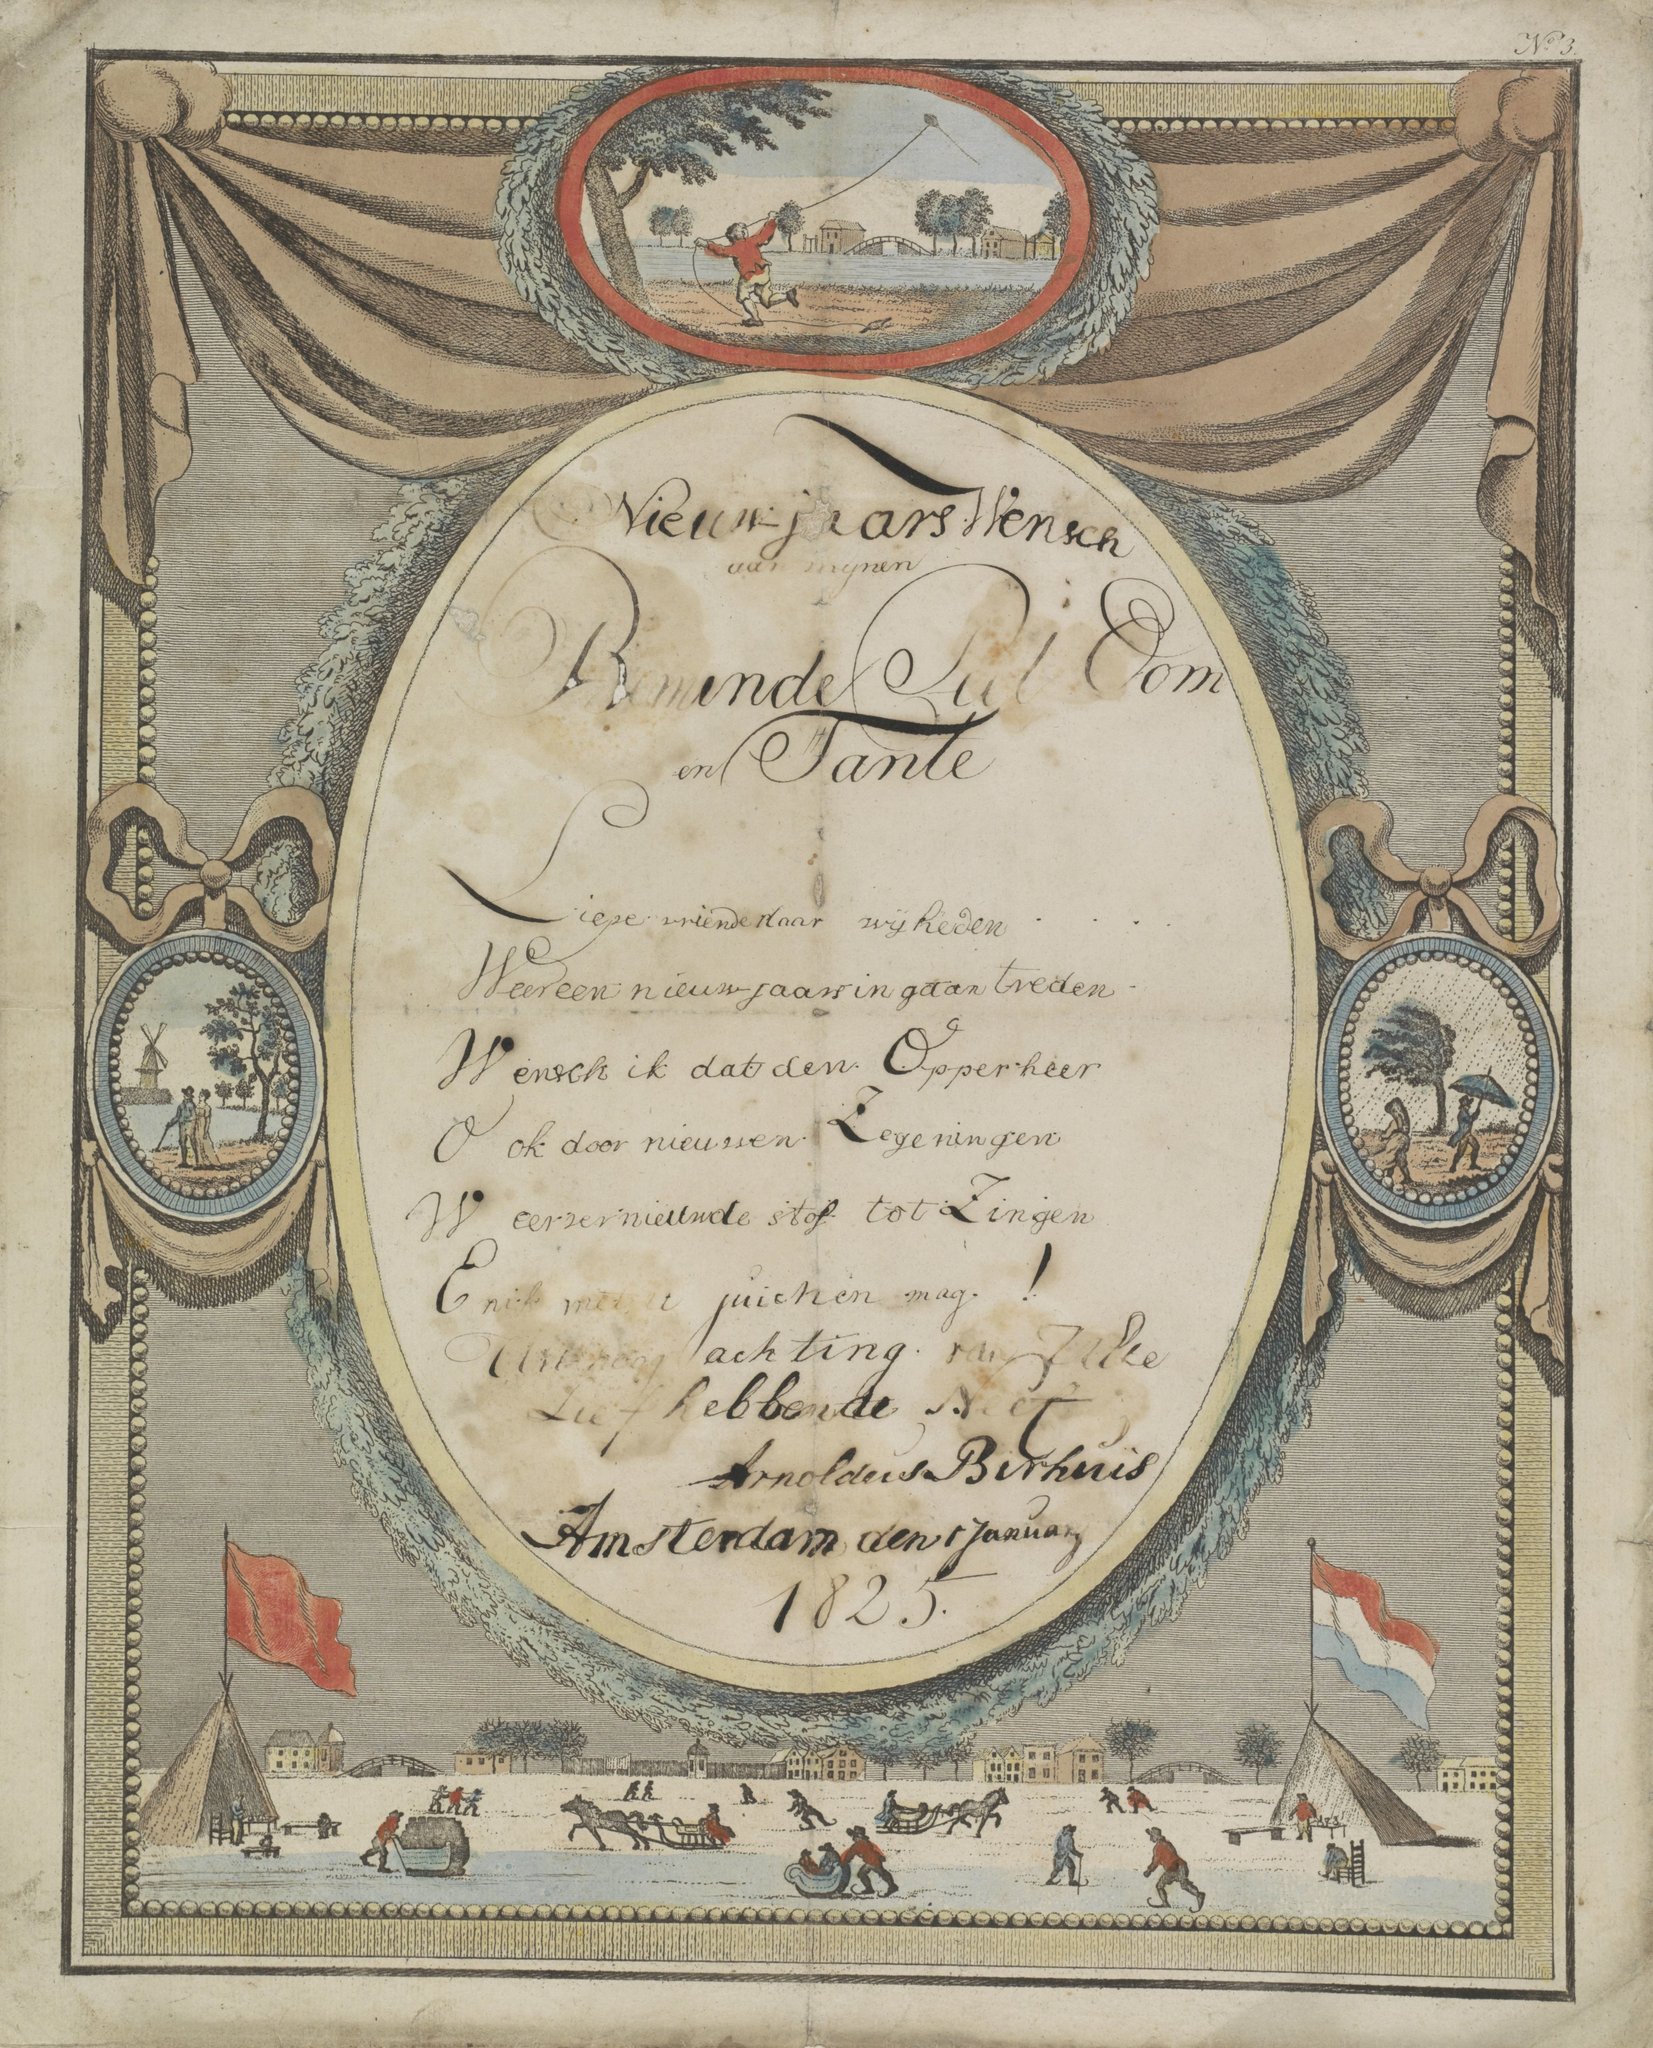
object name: print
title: Wensbrief met wintertafereel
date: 1792-1847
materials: ink, paper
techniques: calligraphy, colour, etching, pen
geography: amsterdam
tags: human types, sleigh, sledge (non-sport), skates (winter sports)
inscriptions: collector's mark: Lugt 2760, inscription: ‘Nieuw-jaars wensch / aan mynen / Beminde peet oom / en tante / Lieve vrienden daar wij heden ...’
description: Wensbrief met beschreven cartouche binnen een decoratief kader met een wintertafereel met schaatsende en sleeënde mensen. In kleine medaillons voorstellingen van een wandelend paar, een vliegerend jongetje en van mensen in de regen. Handgeschreven bericht in kalligrafie (Nieuwjaarswens) door Arnoldus Birhuis aan zijn peetoom en tante. Genummerd rechtsboven: No. 3.